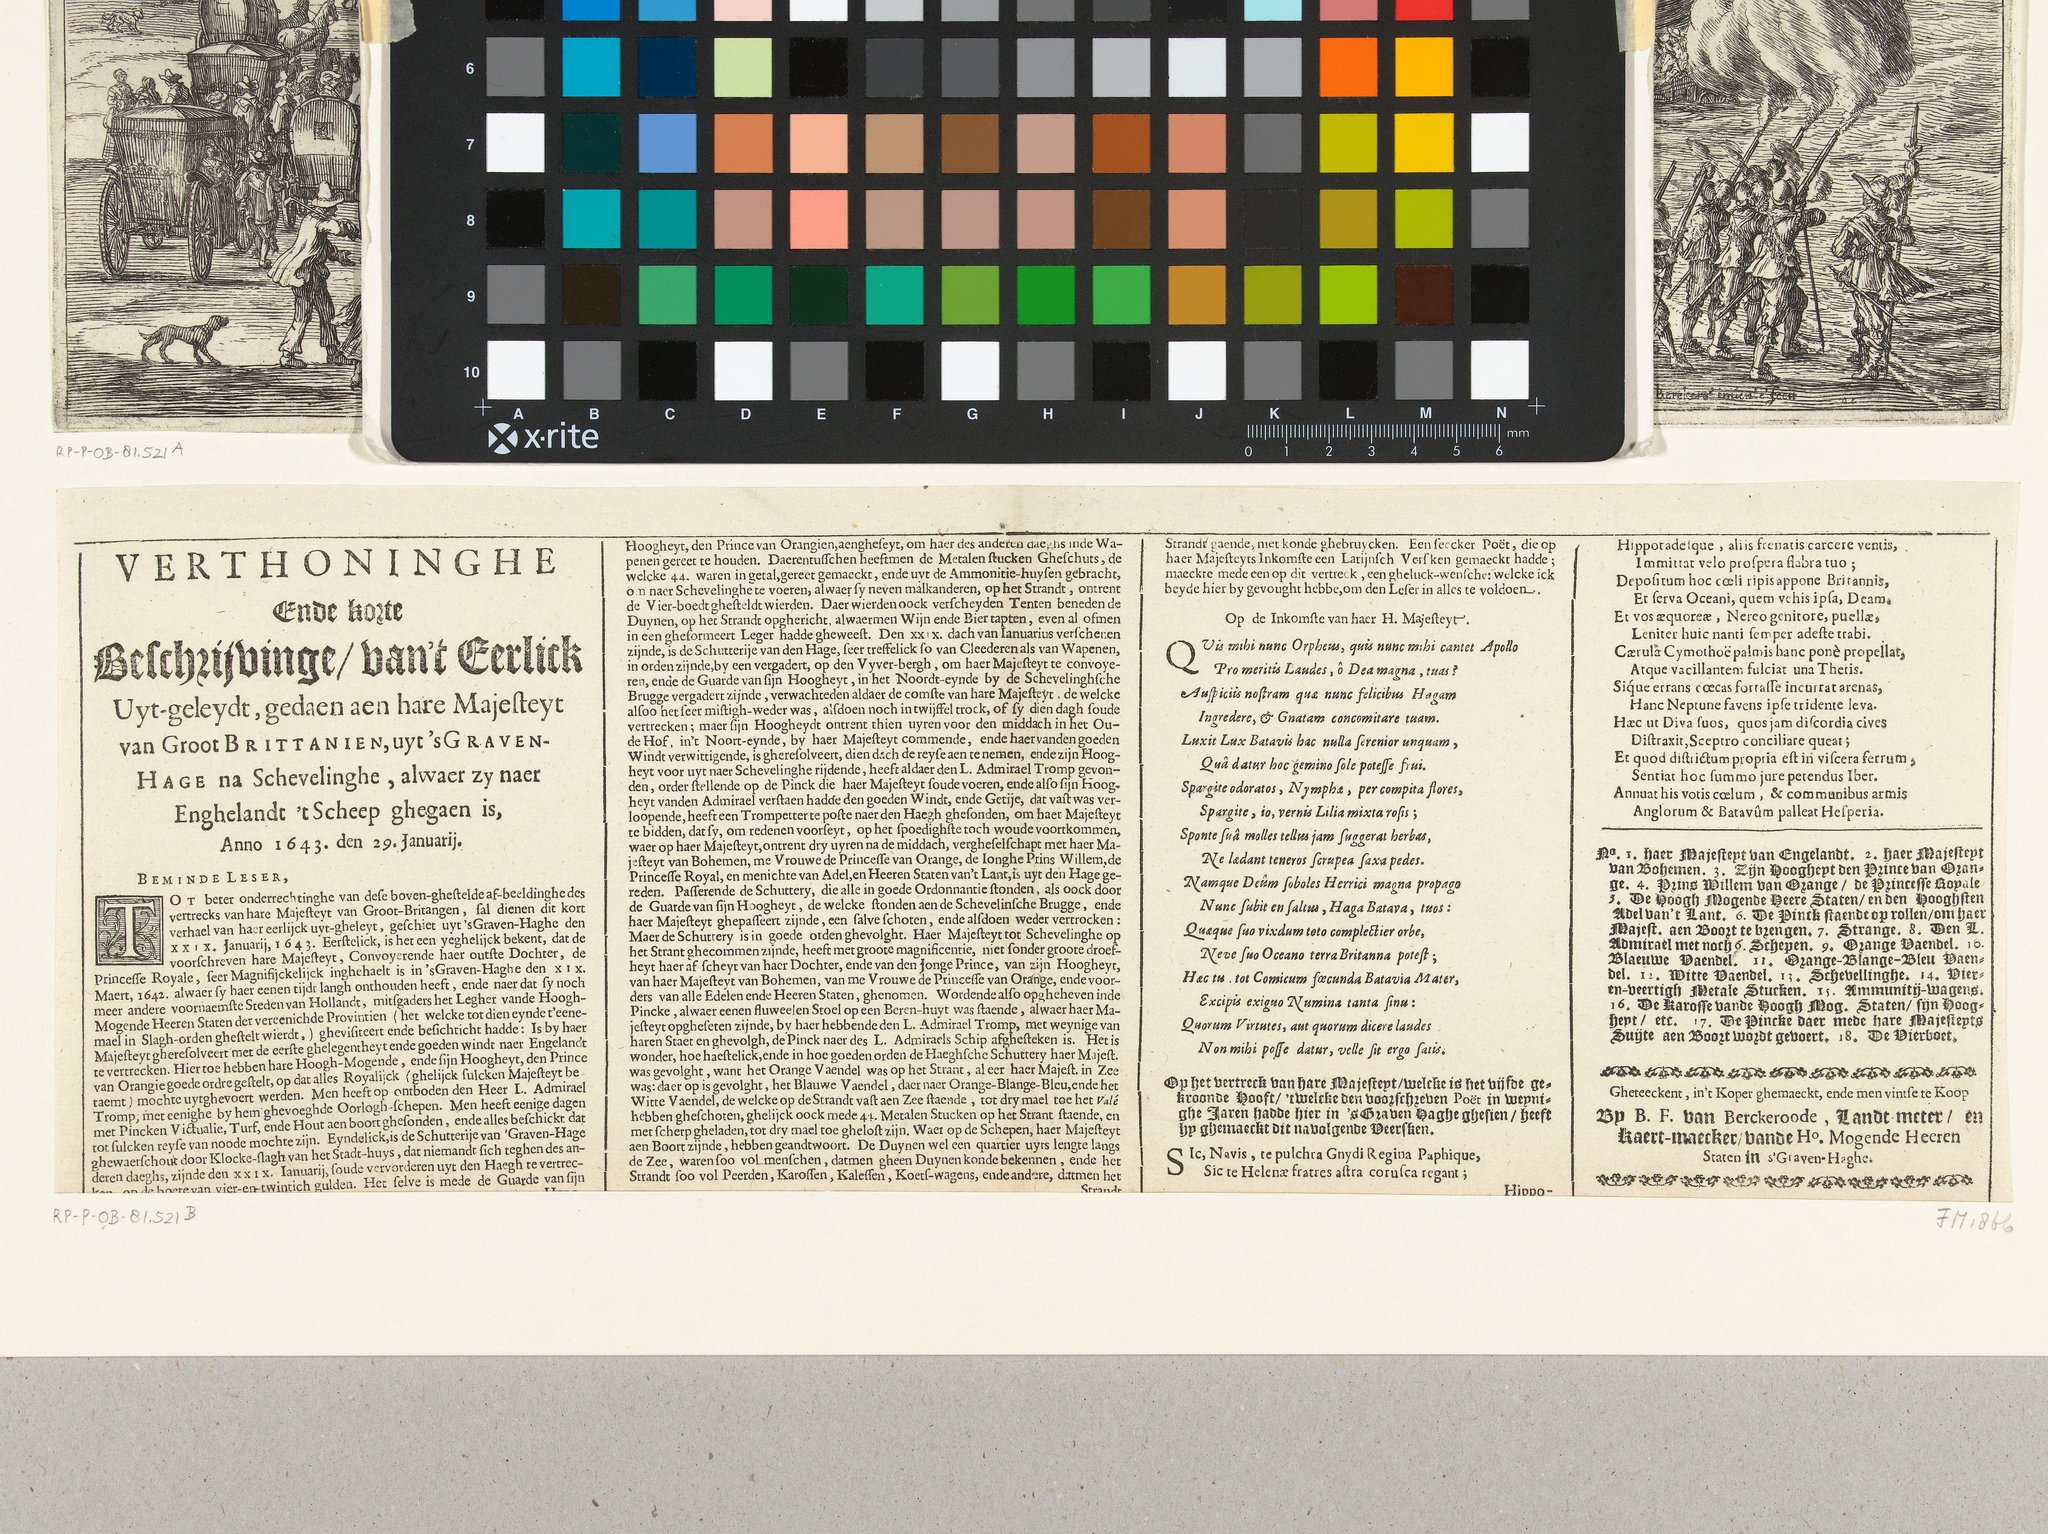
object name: print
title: Verthoninghe Ende korte Beschrijvinge / van't Eerlick Uyt-geleydt, gedaen aen hare Majesteyt van Groot Brittanien, uyt 'sGraven-Hage na Schevelinghe, alwaer zy naer Enghelandt 't Scheep ghegaen is, Anno 1643. den 29. Januarij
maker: balthasar florisz. van berckenrode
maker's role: draughtsman, print maker, publisher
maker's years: 1591-1645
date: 1643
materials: paper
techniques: letterpress printing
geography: the hague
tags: henriëtta maria van frankrijk (koningin van engeland, schotland en ierland)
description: Tekstblad bij de prent met het vertrek van de Engelse koningin Henrietta Maria vanuit Scheveningen naar Engeland, 29 januari 1643. Tekst in 4 kolommen met twee verzen in het Latijn en de legenda 1-18 in het Nederlands.